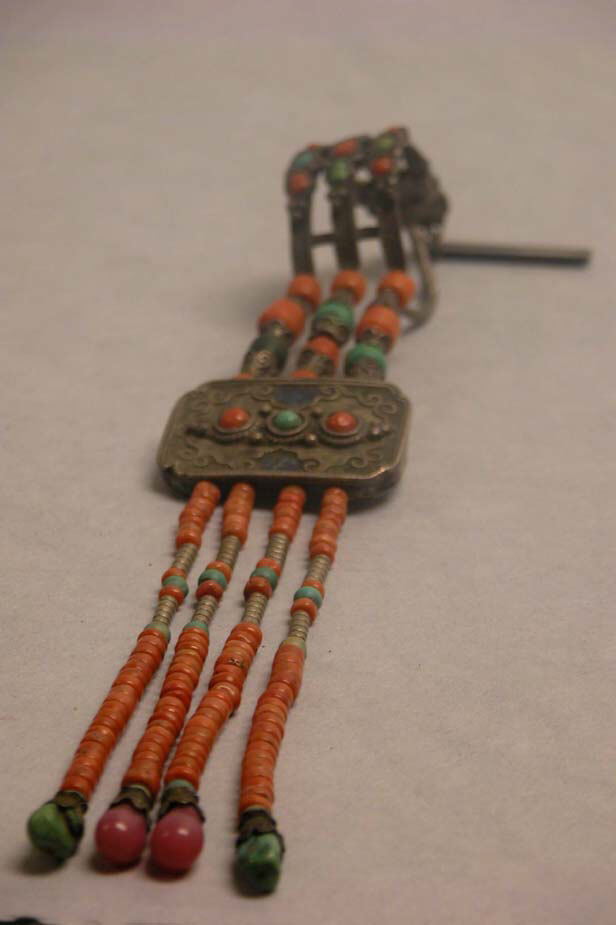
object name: earring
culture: tibetan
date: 1801-1900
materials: jade, silver